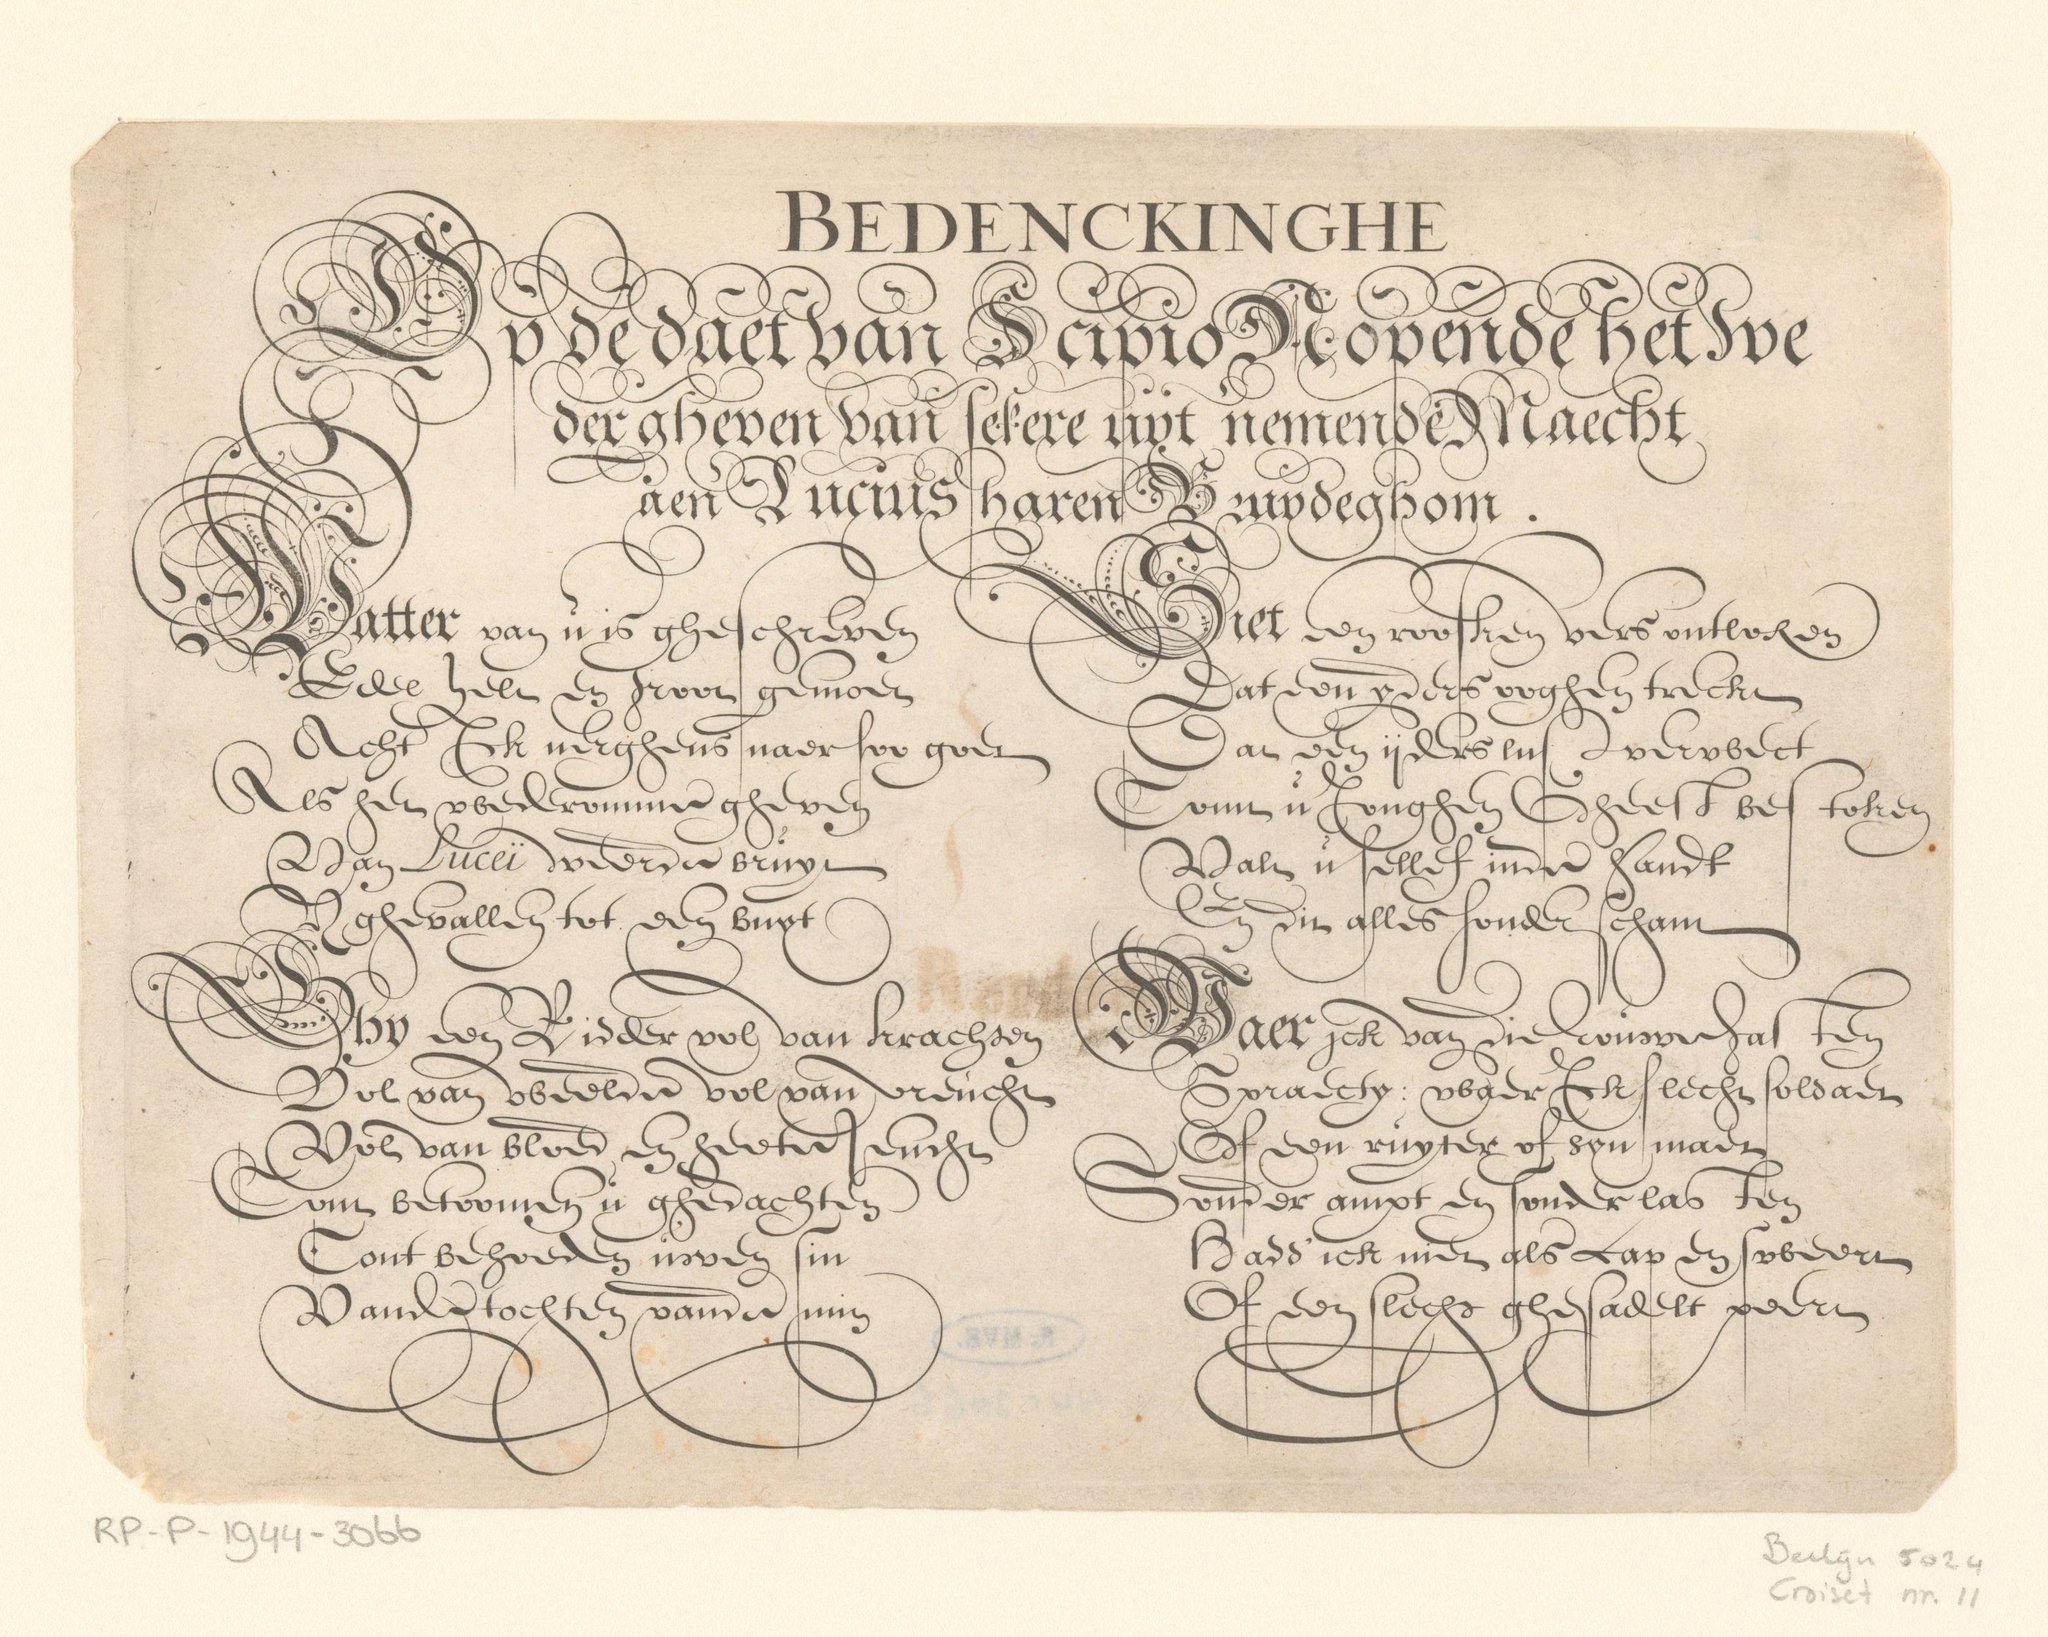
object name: print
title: Gedicht 'Bedenckinghe Op de daet van Scipio'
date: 1600-1650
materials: paper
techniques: engraving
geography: northern netherlands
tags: calligraphy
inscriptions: collector's mark: Lugt 2228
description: Gekalligrafeerde tekst: Bedenckinghe Op de daet van Scipio (...). In vier stanza's.